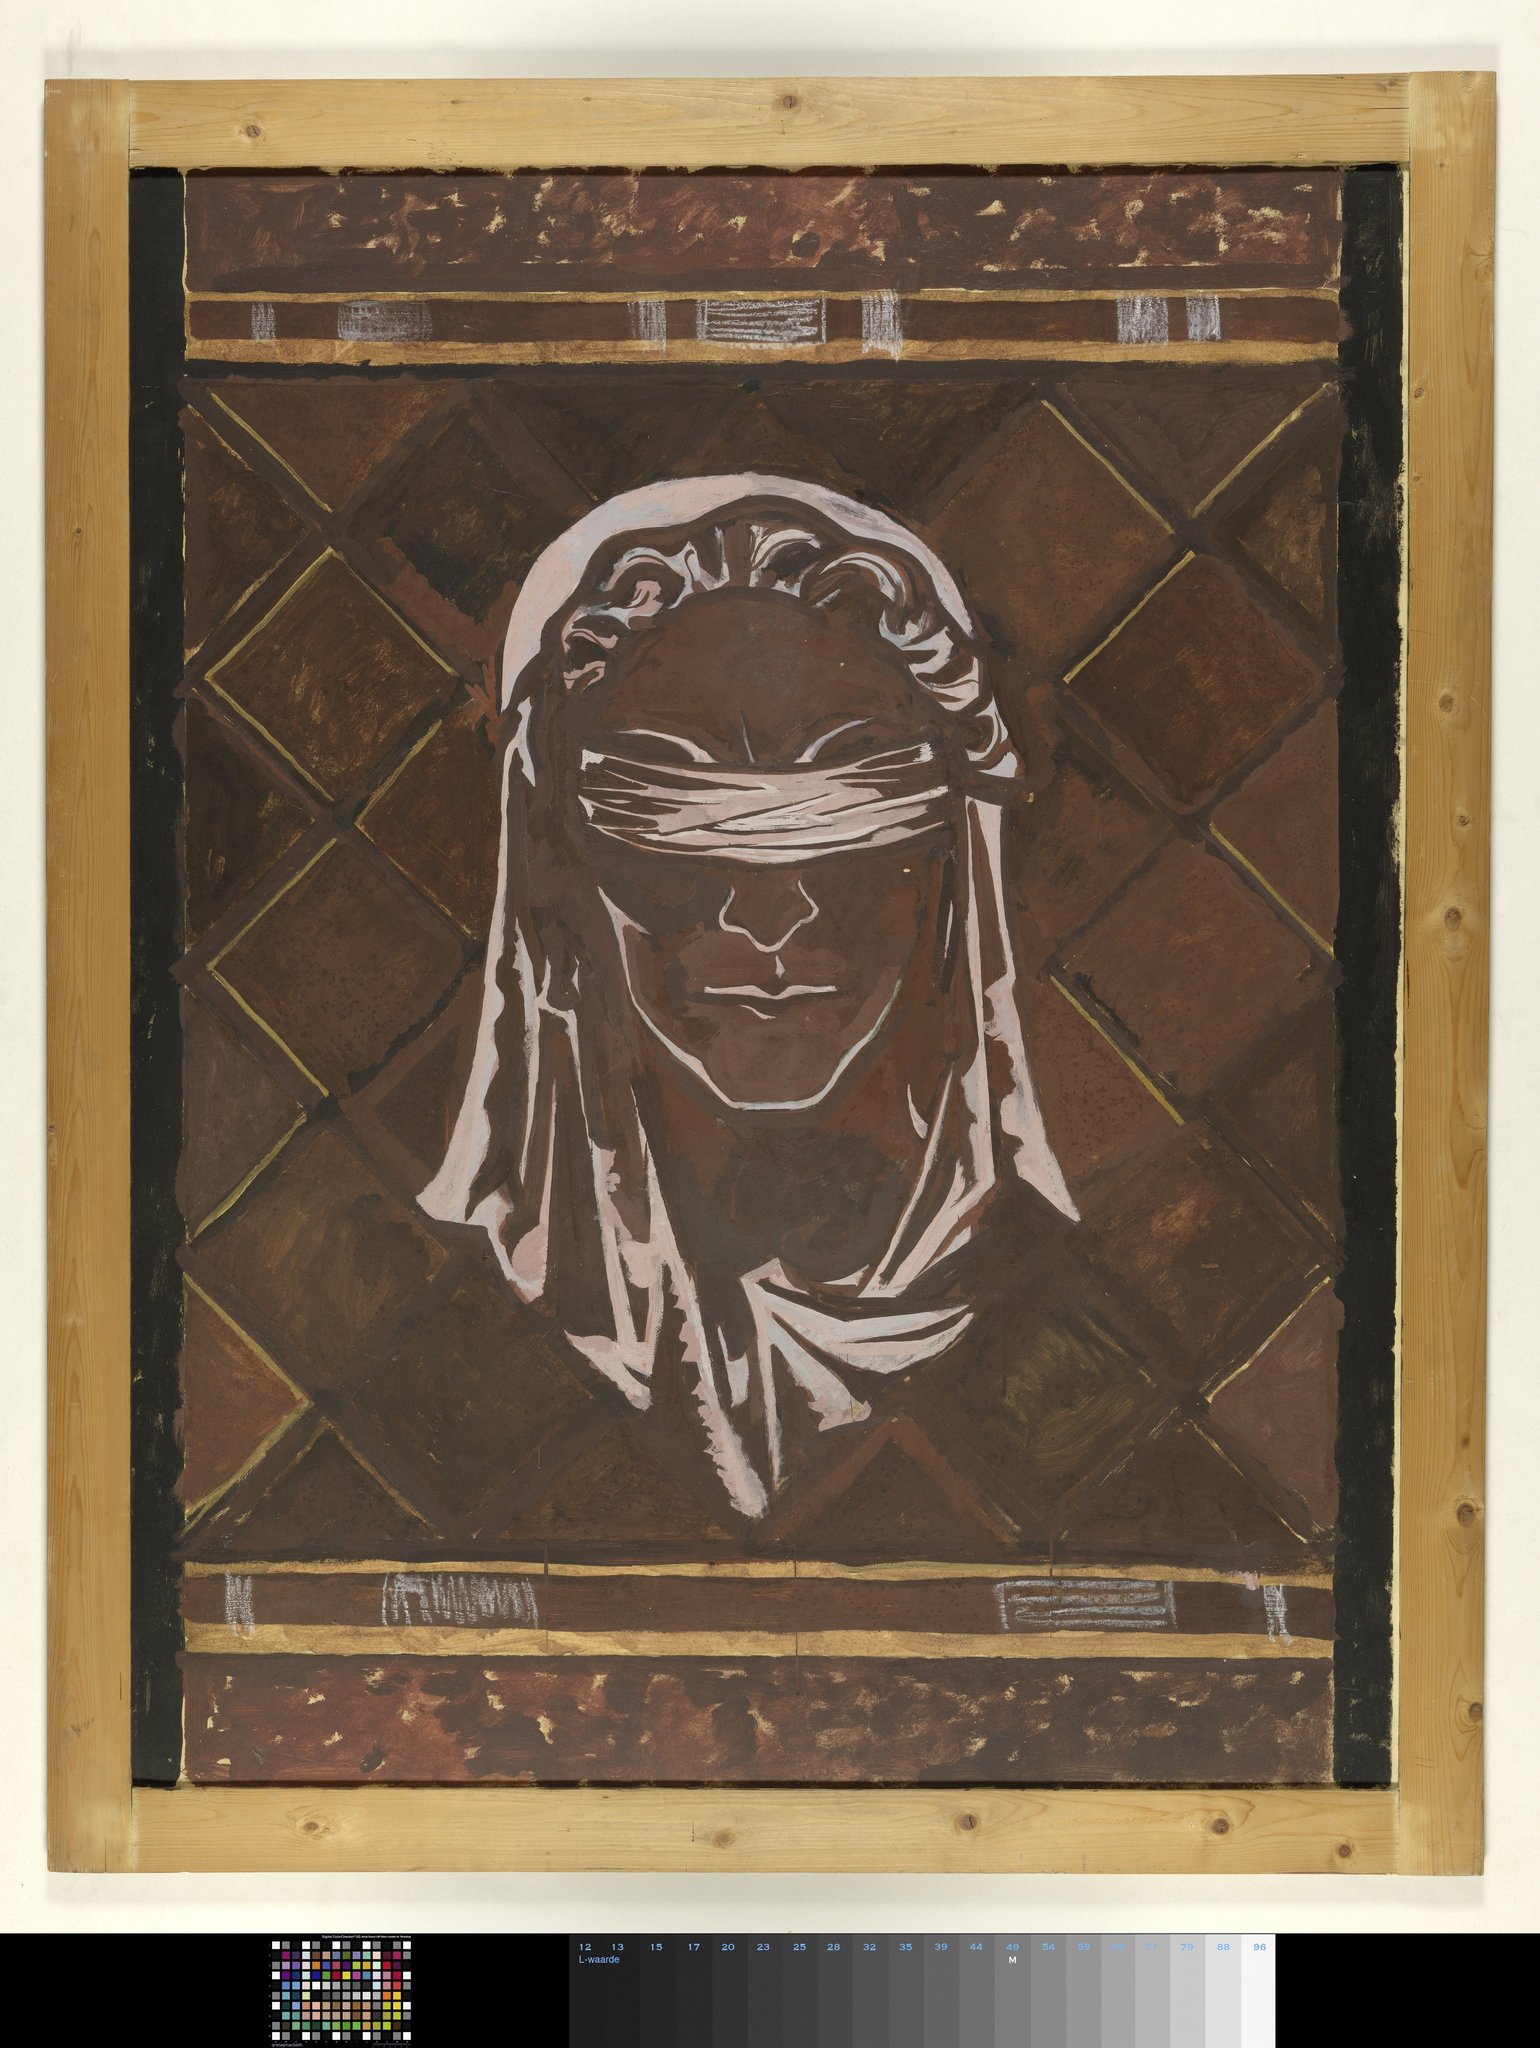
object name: drawing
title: Kop van de geblinddoekte Justitia; ontwerp voor figuur van de marmerdecoratie in de Hoge Raad te Den Haag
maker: richard nicolaüs roland holst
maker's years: 1868-1938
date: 1868-1938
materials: cardboard, chalk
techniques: brush